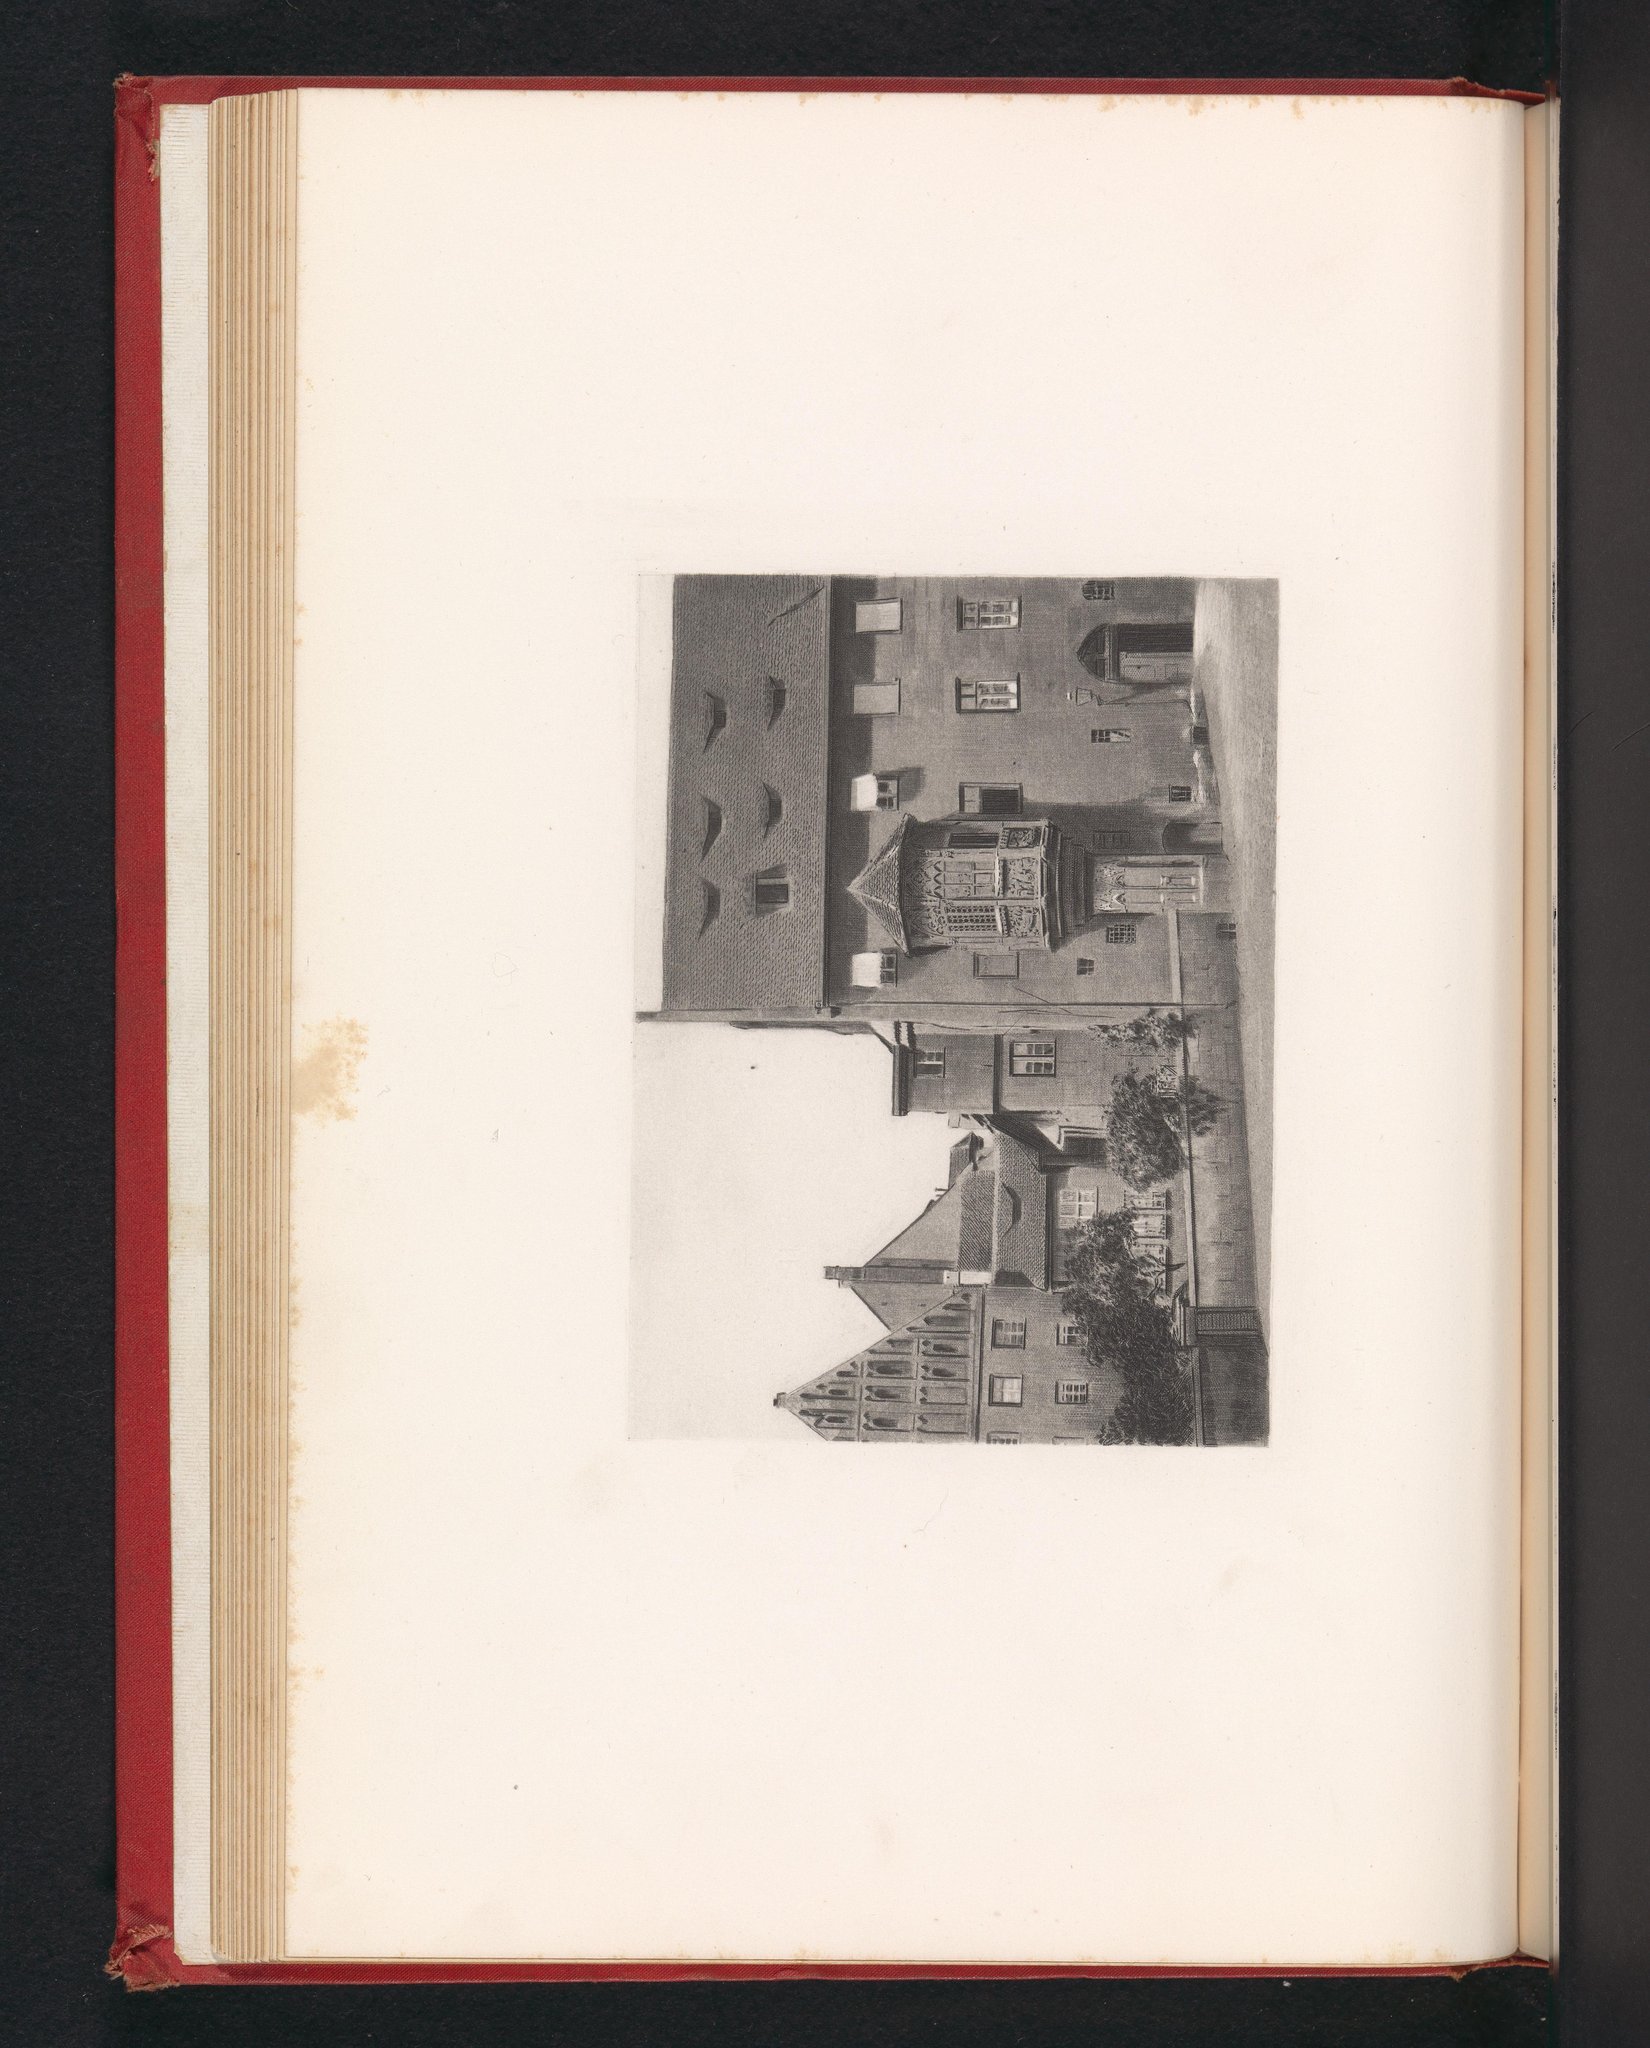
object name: photomechanical print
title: St. Sebald's Rectory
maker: Anonymous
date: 1878-1888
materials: paper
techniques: photoaquatint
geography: philadelphia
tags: church (exterior)